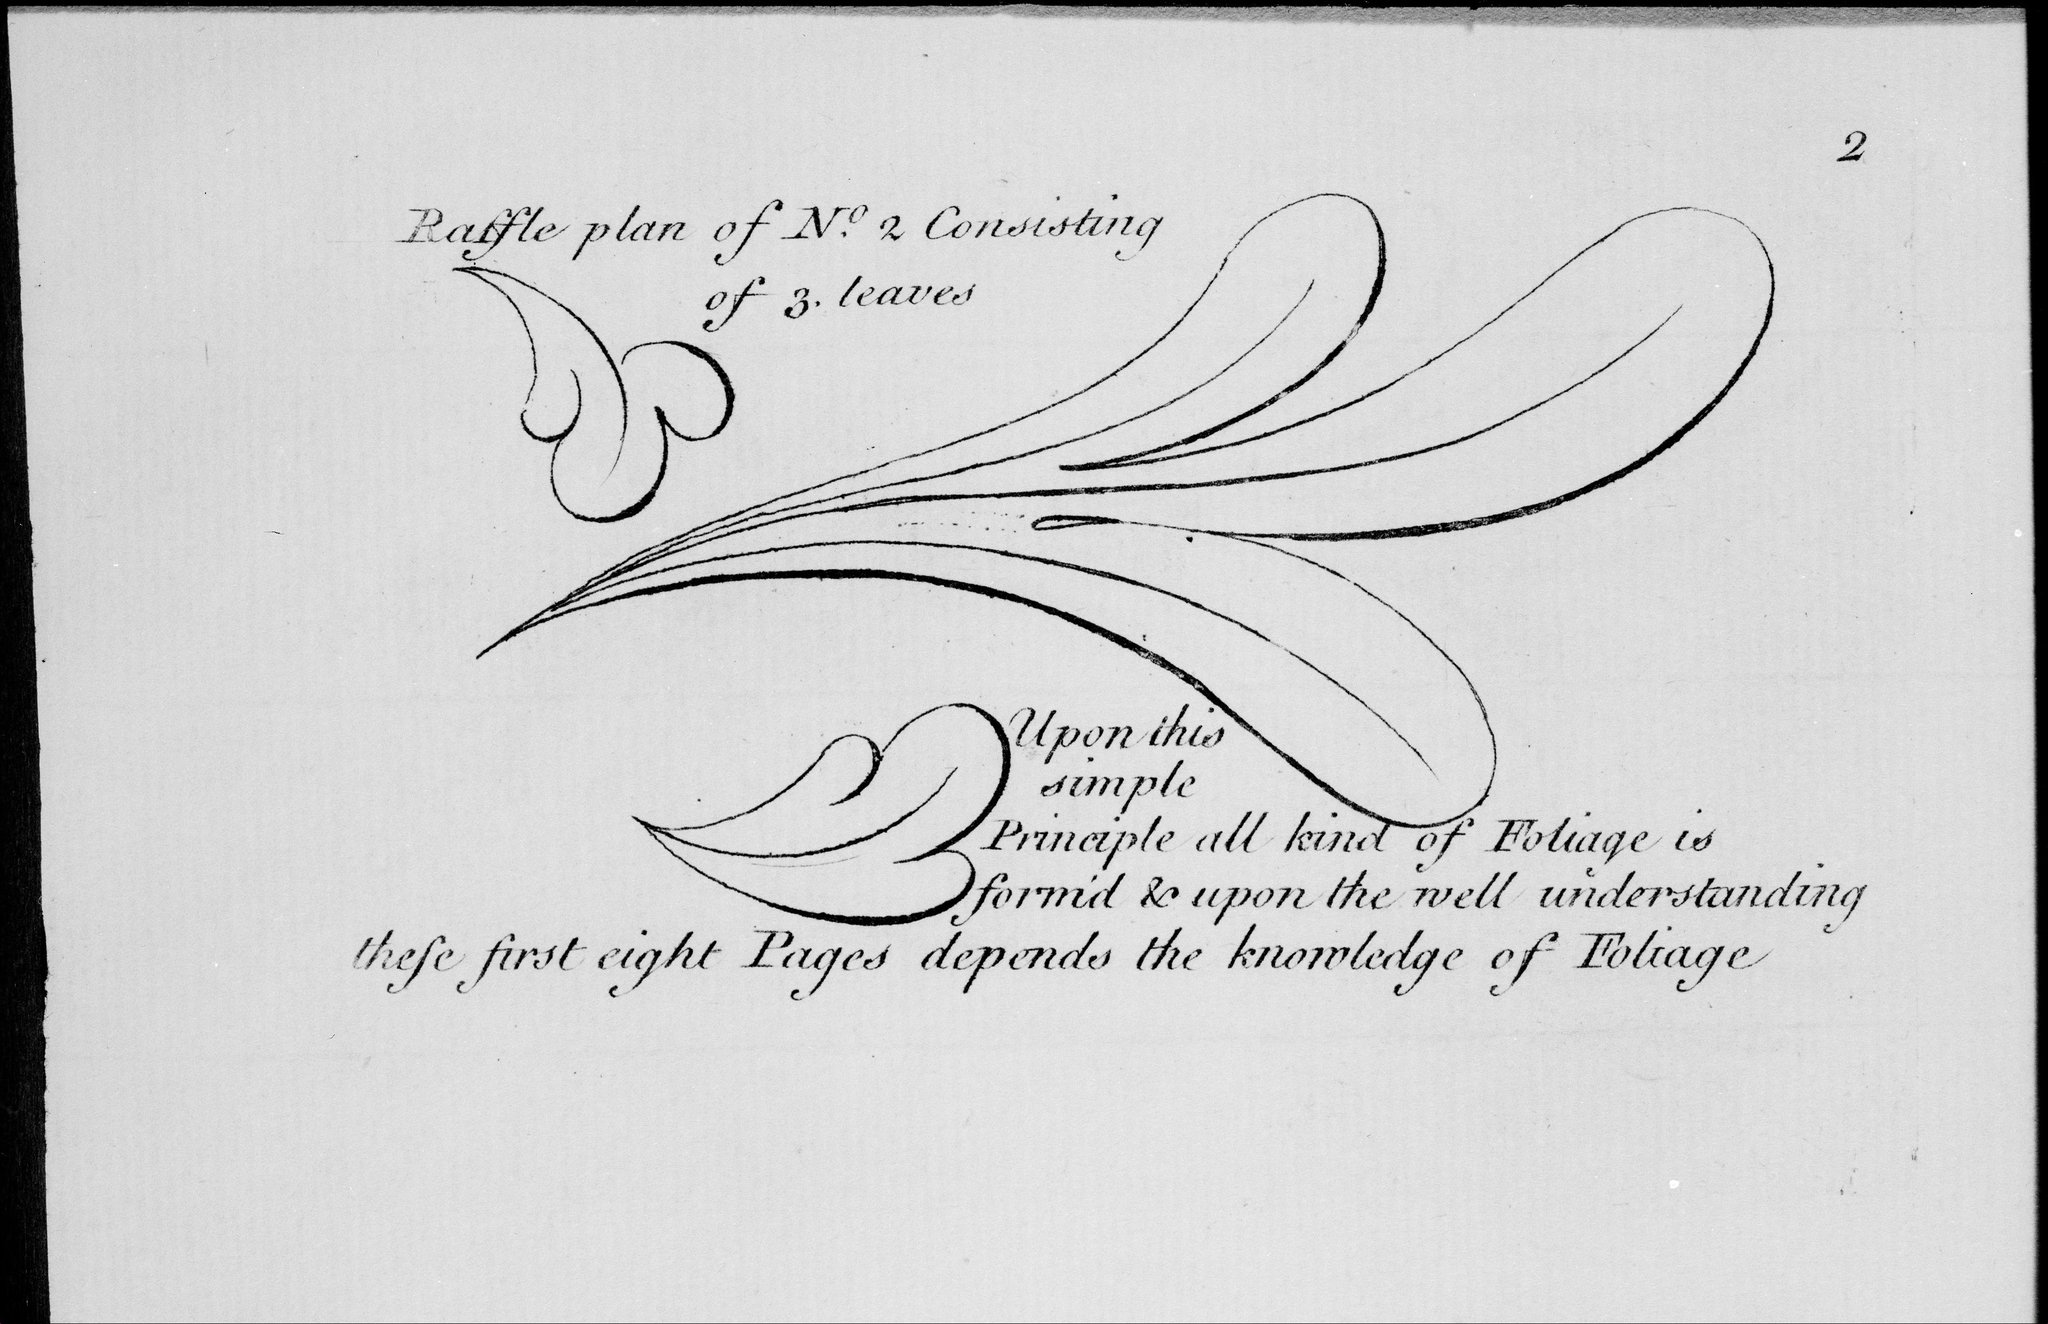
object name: book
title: The Principles of Ornament, or the Youth's Guide to the Drawing of Foliage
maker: matthias lock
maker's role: designer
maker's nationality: british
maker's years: 1705-1760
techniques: engraving, etching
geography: england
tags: leaves